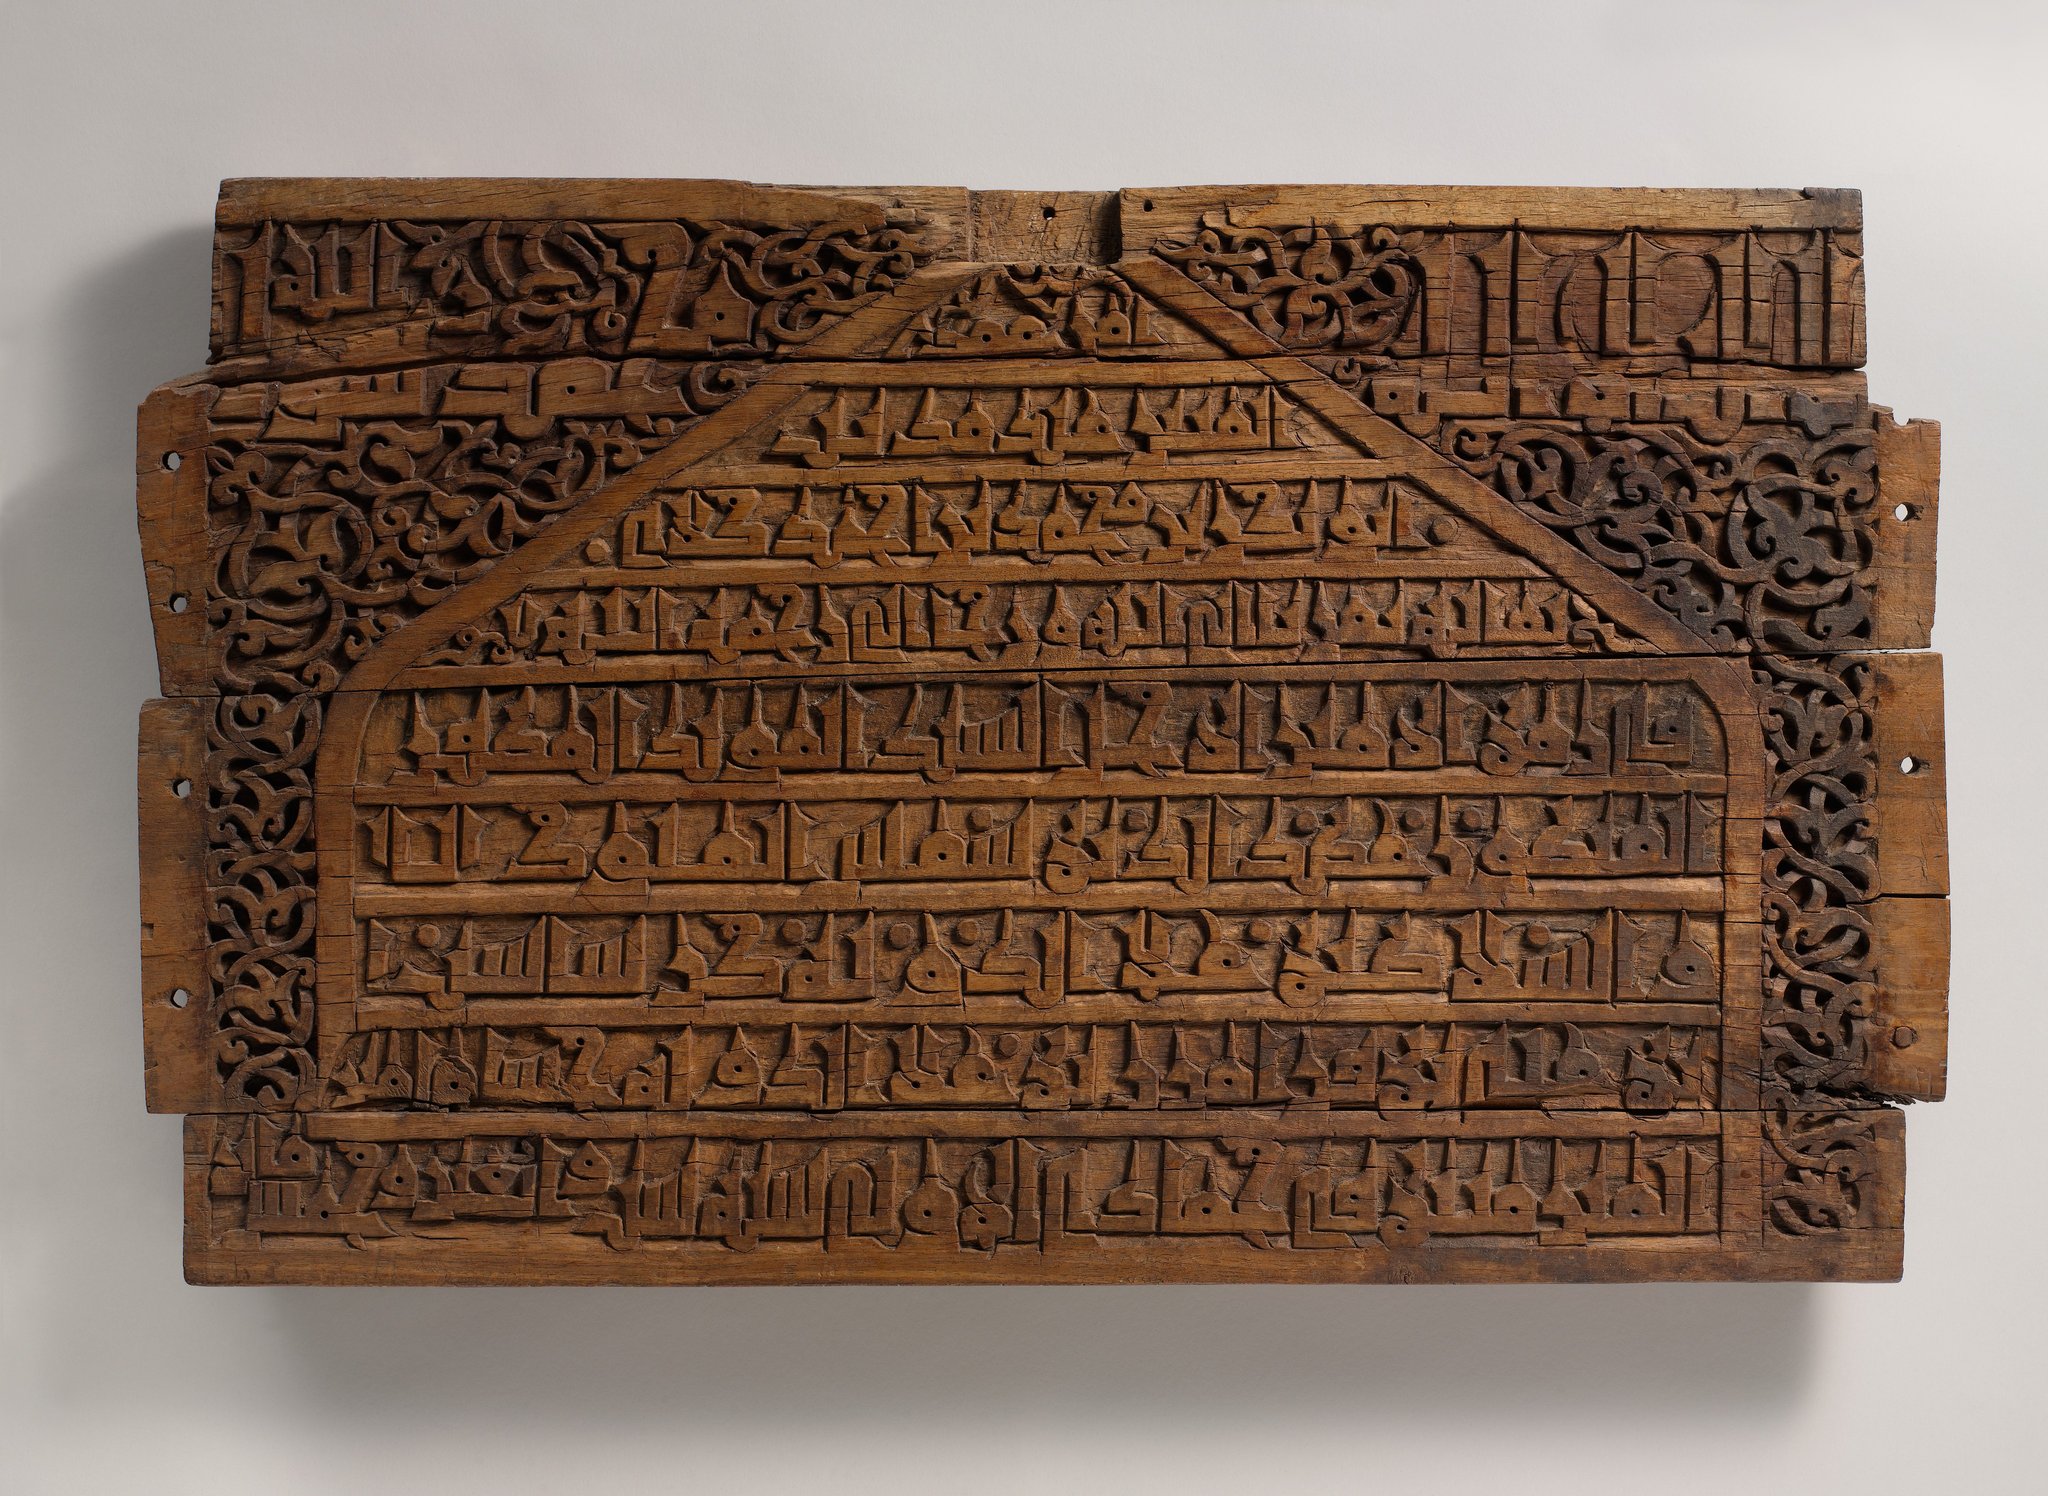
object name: fragment of a pulpit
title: Two elements from the minbar of Abu Bakr ibn Muhammad ibn Ahmad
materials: wood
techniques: carving, painting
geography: iran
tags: arabic